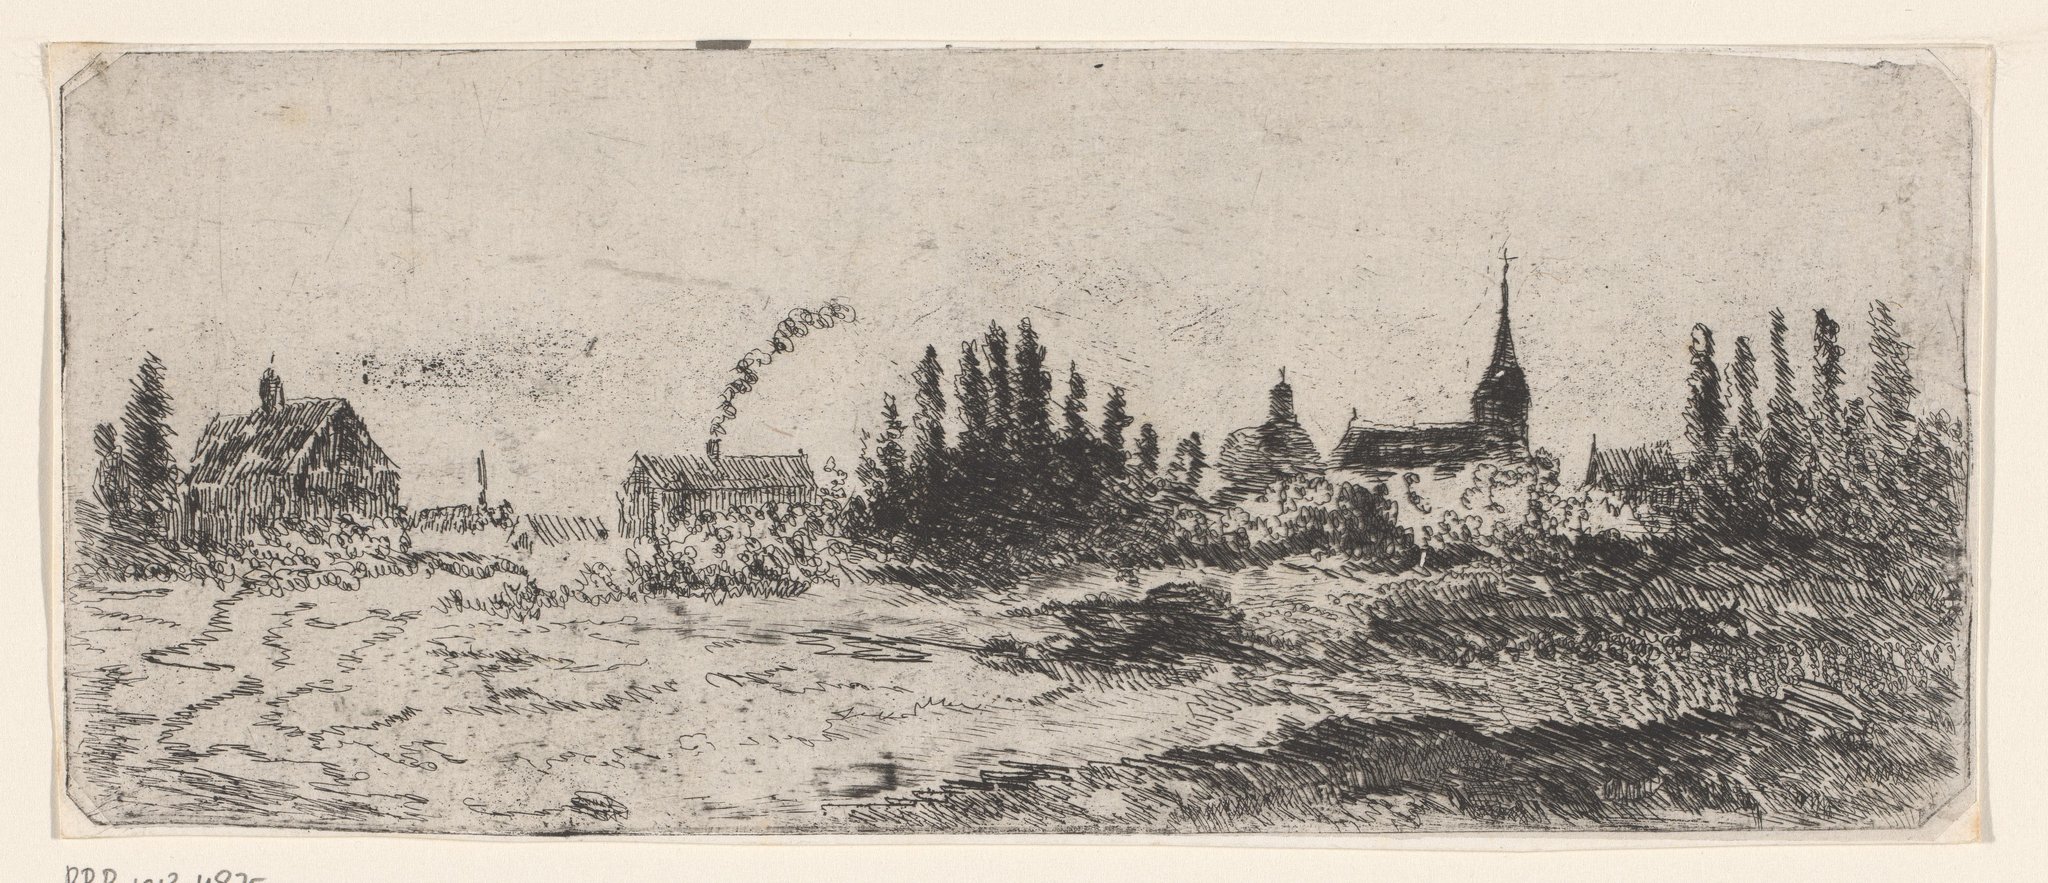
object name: print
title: Landschap met een dorpsgezicht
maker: arnoud schaepkens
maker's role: print maker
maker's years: 1816-1904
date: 1831-1904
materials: paper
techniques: drypoint, etching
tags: prospect of village, silhouette of village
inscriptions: collector's mark: Lugt 2228